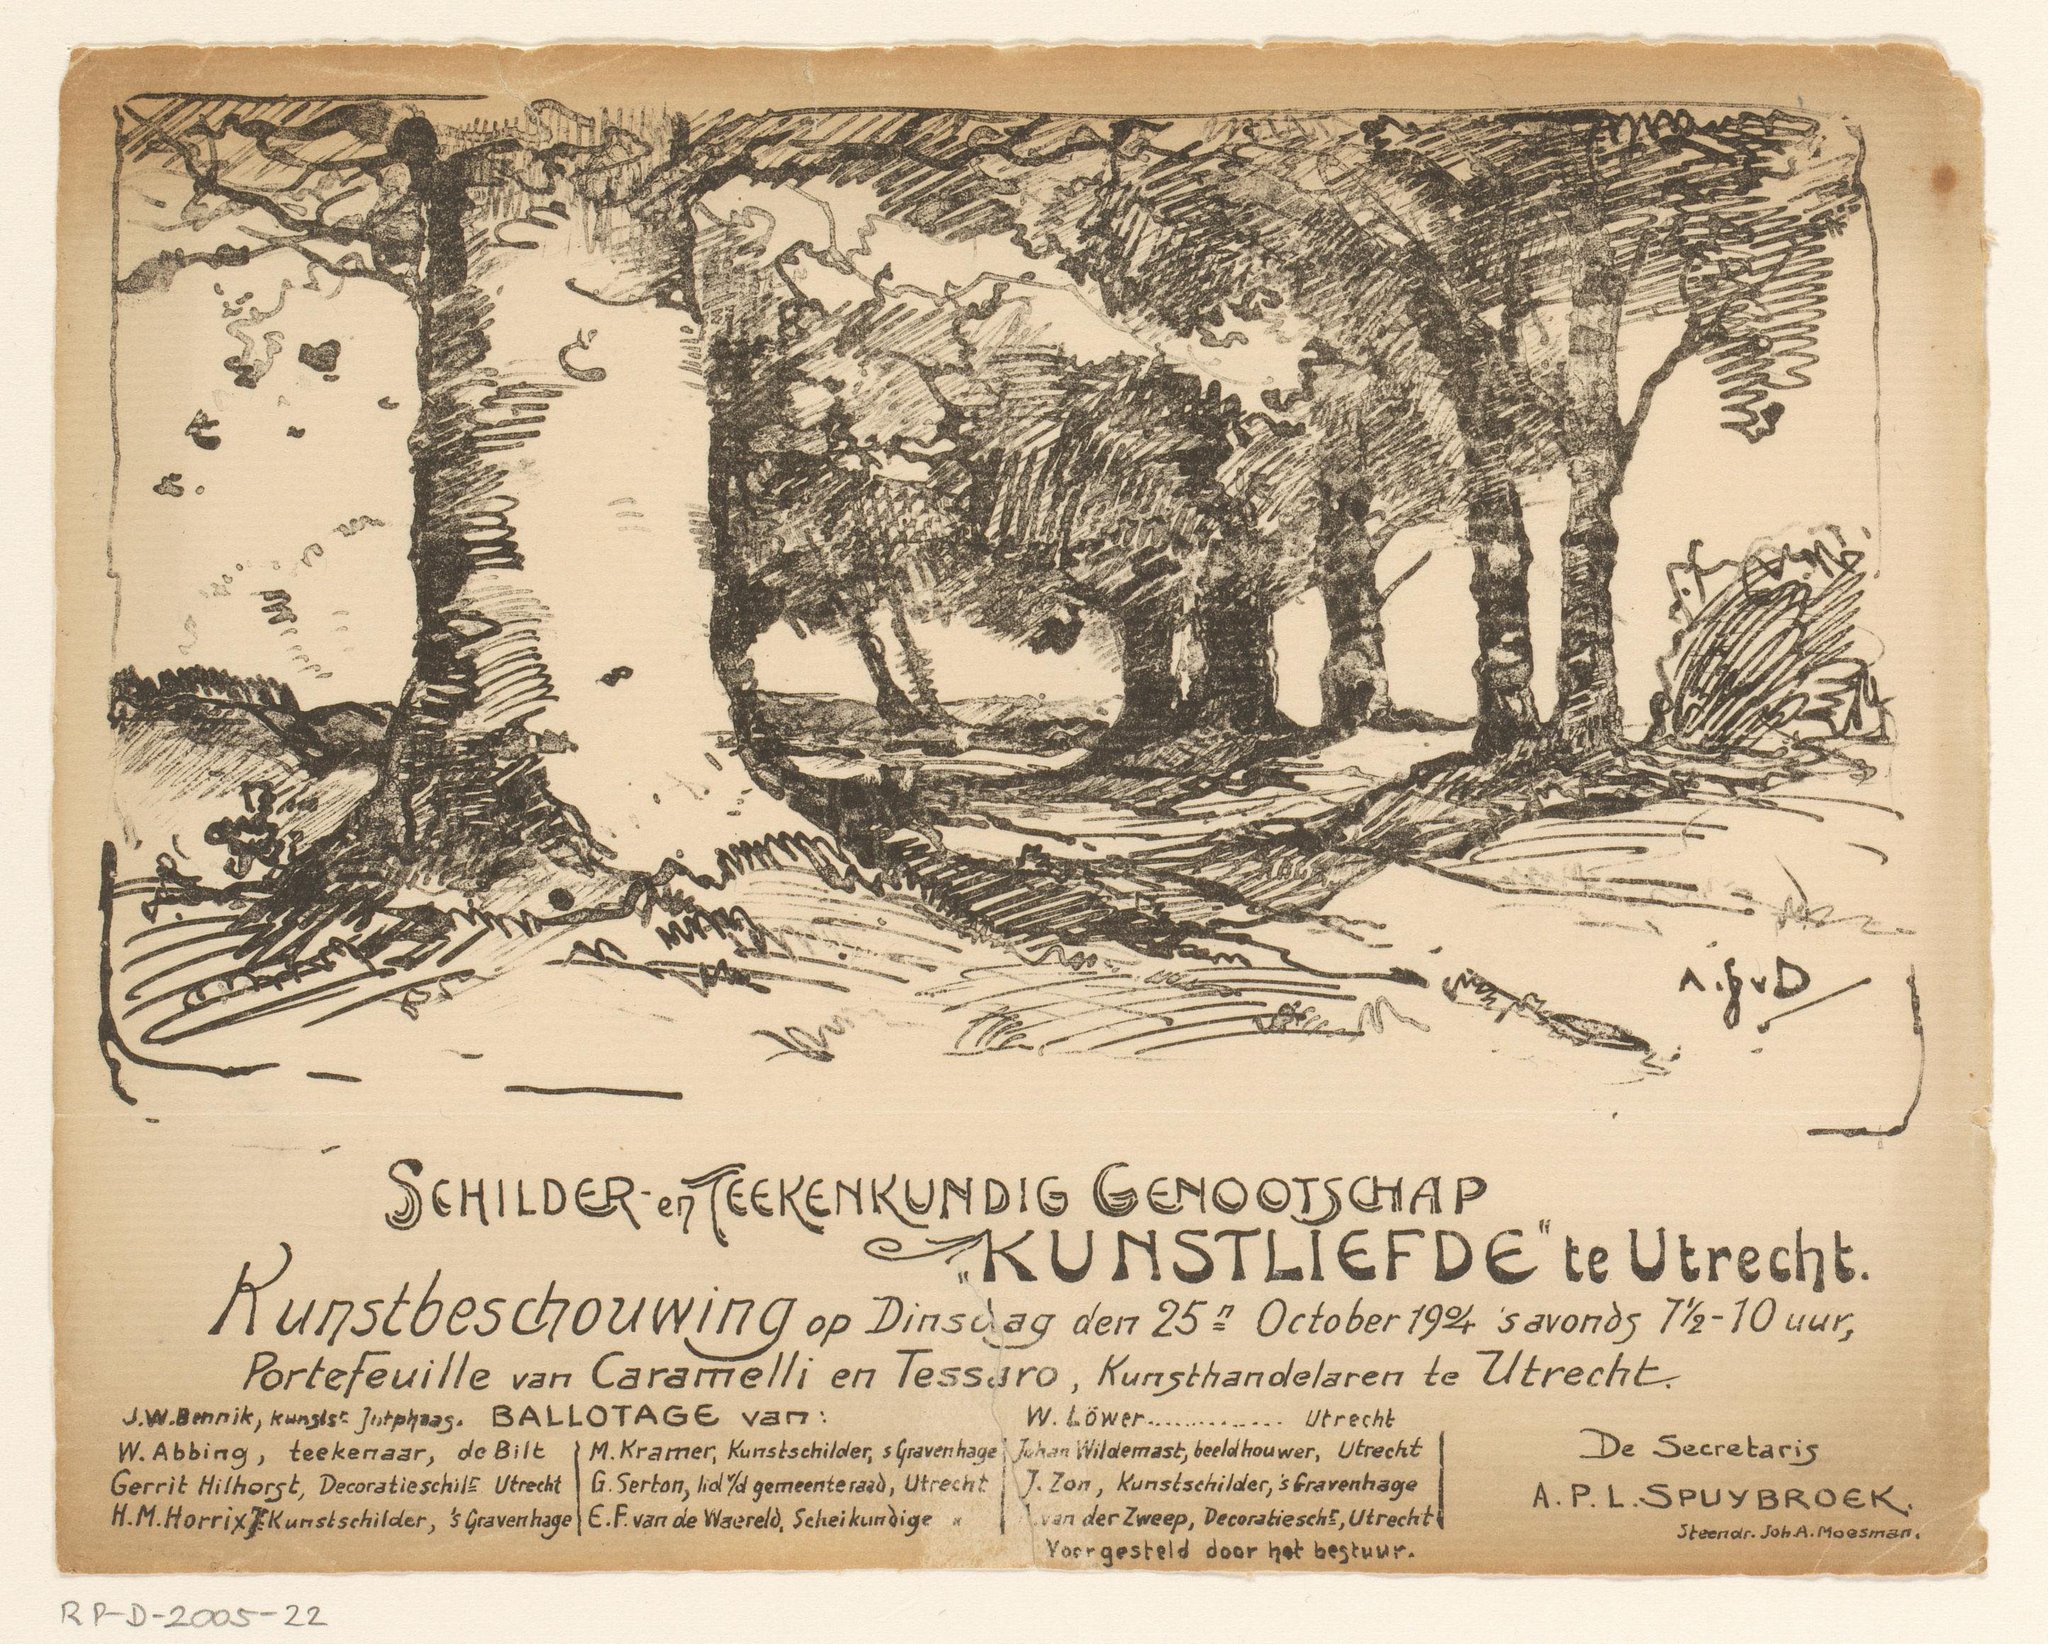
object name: invitation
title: Uitnodiging van Schilder- en Teekenkundig Genootschap "Kunstliefde" voor een kunstbeschouwing, 25 oktober 1904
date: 1904-1910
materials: paper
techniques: lithograph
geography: utrecht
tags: criticizing and discussing art, art criticism, circle, club of artists, collecting and exhibiting products of the fine arts, groups of trees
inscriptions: collector's mark: Lugt 2228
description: Groepje bomen. Uitnodiging van Schilder- en Teekenkundig Genootschap "Kunstliefde" voor een kunstbeschouwing op 25 oktober 1904 van de portefeuille van Caramelli en Tessaro, kunsthandelaren te Utrecht.